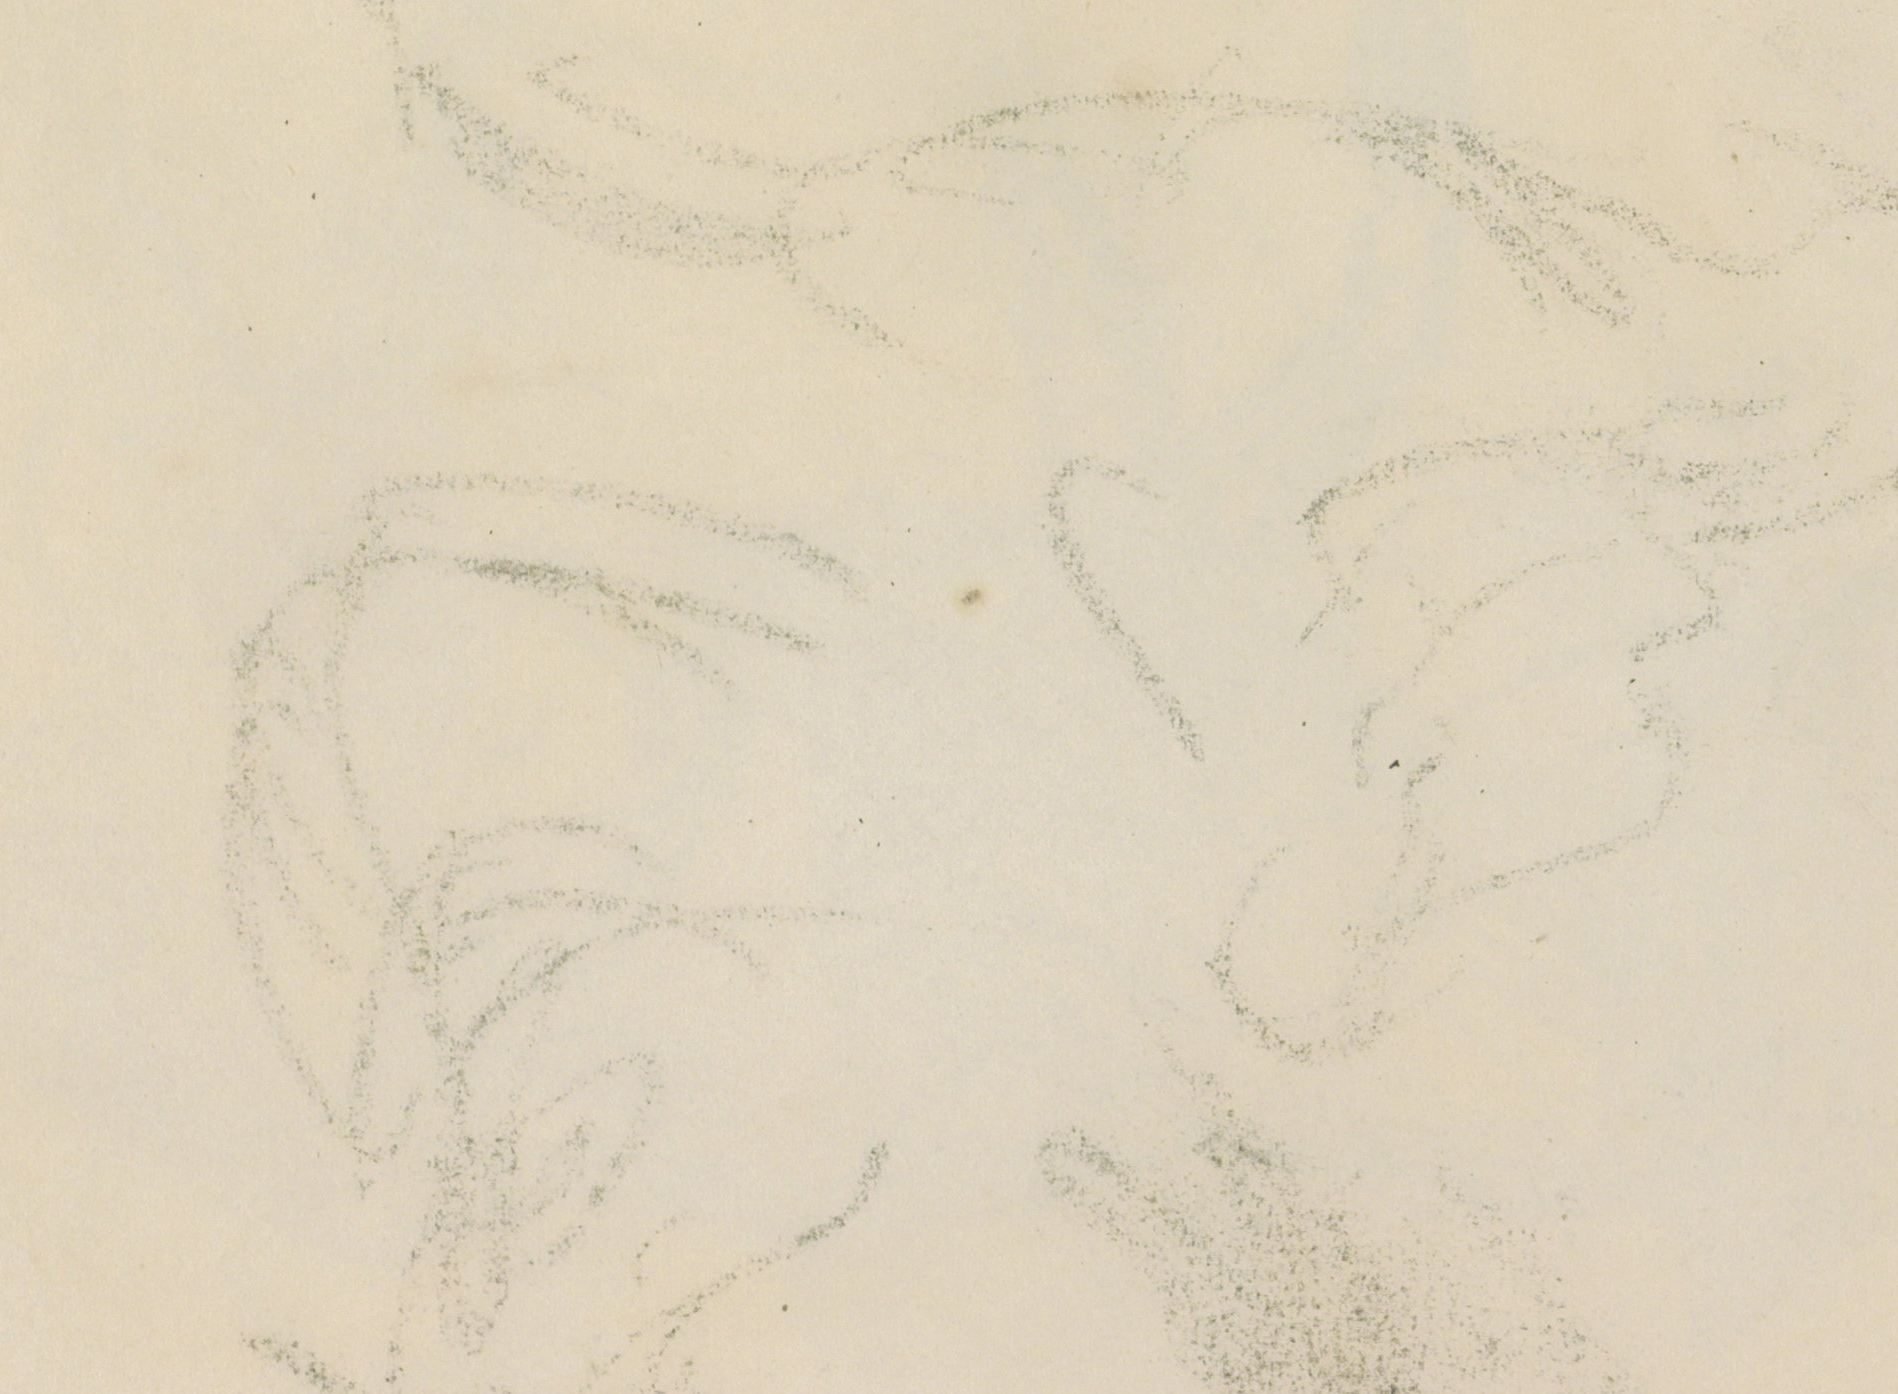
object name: sketchbook leaf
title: Abklatsch van de krijttekening op blad 8 recto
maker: isaac israels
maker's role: draughtsman, painter, print maker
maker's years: 1865-1934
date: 1890-1920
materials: paper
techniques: printmaking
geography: the hague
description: Blad 7 verso uit schetsboek X met 43 bladen.